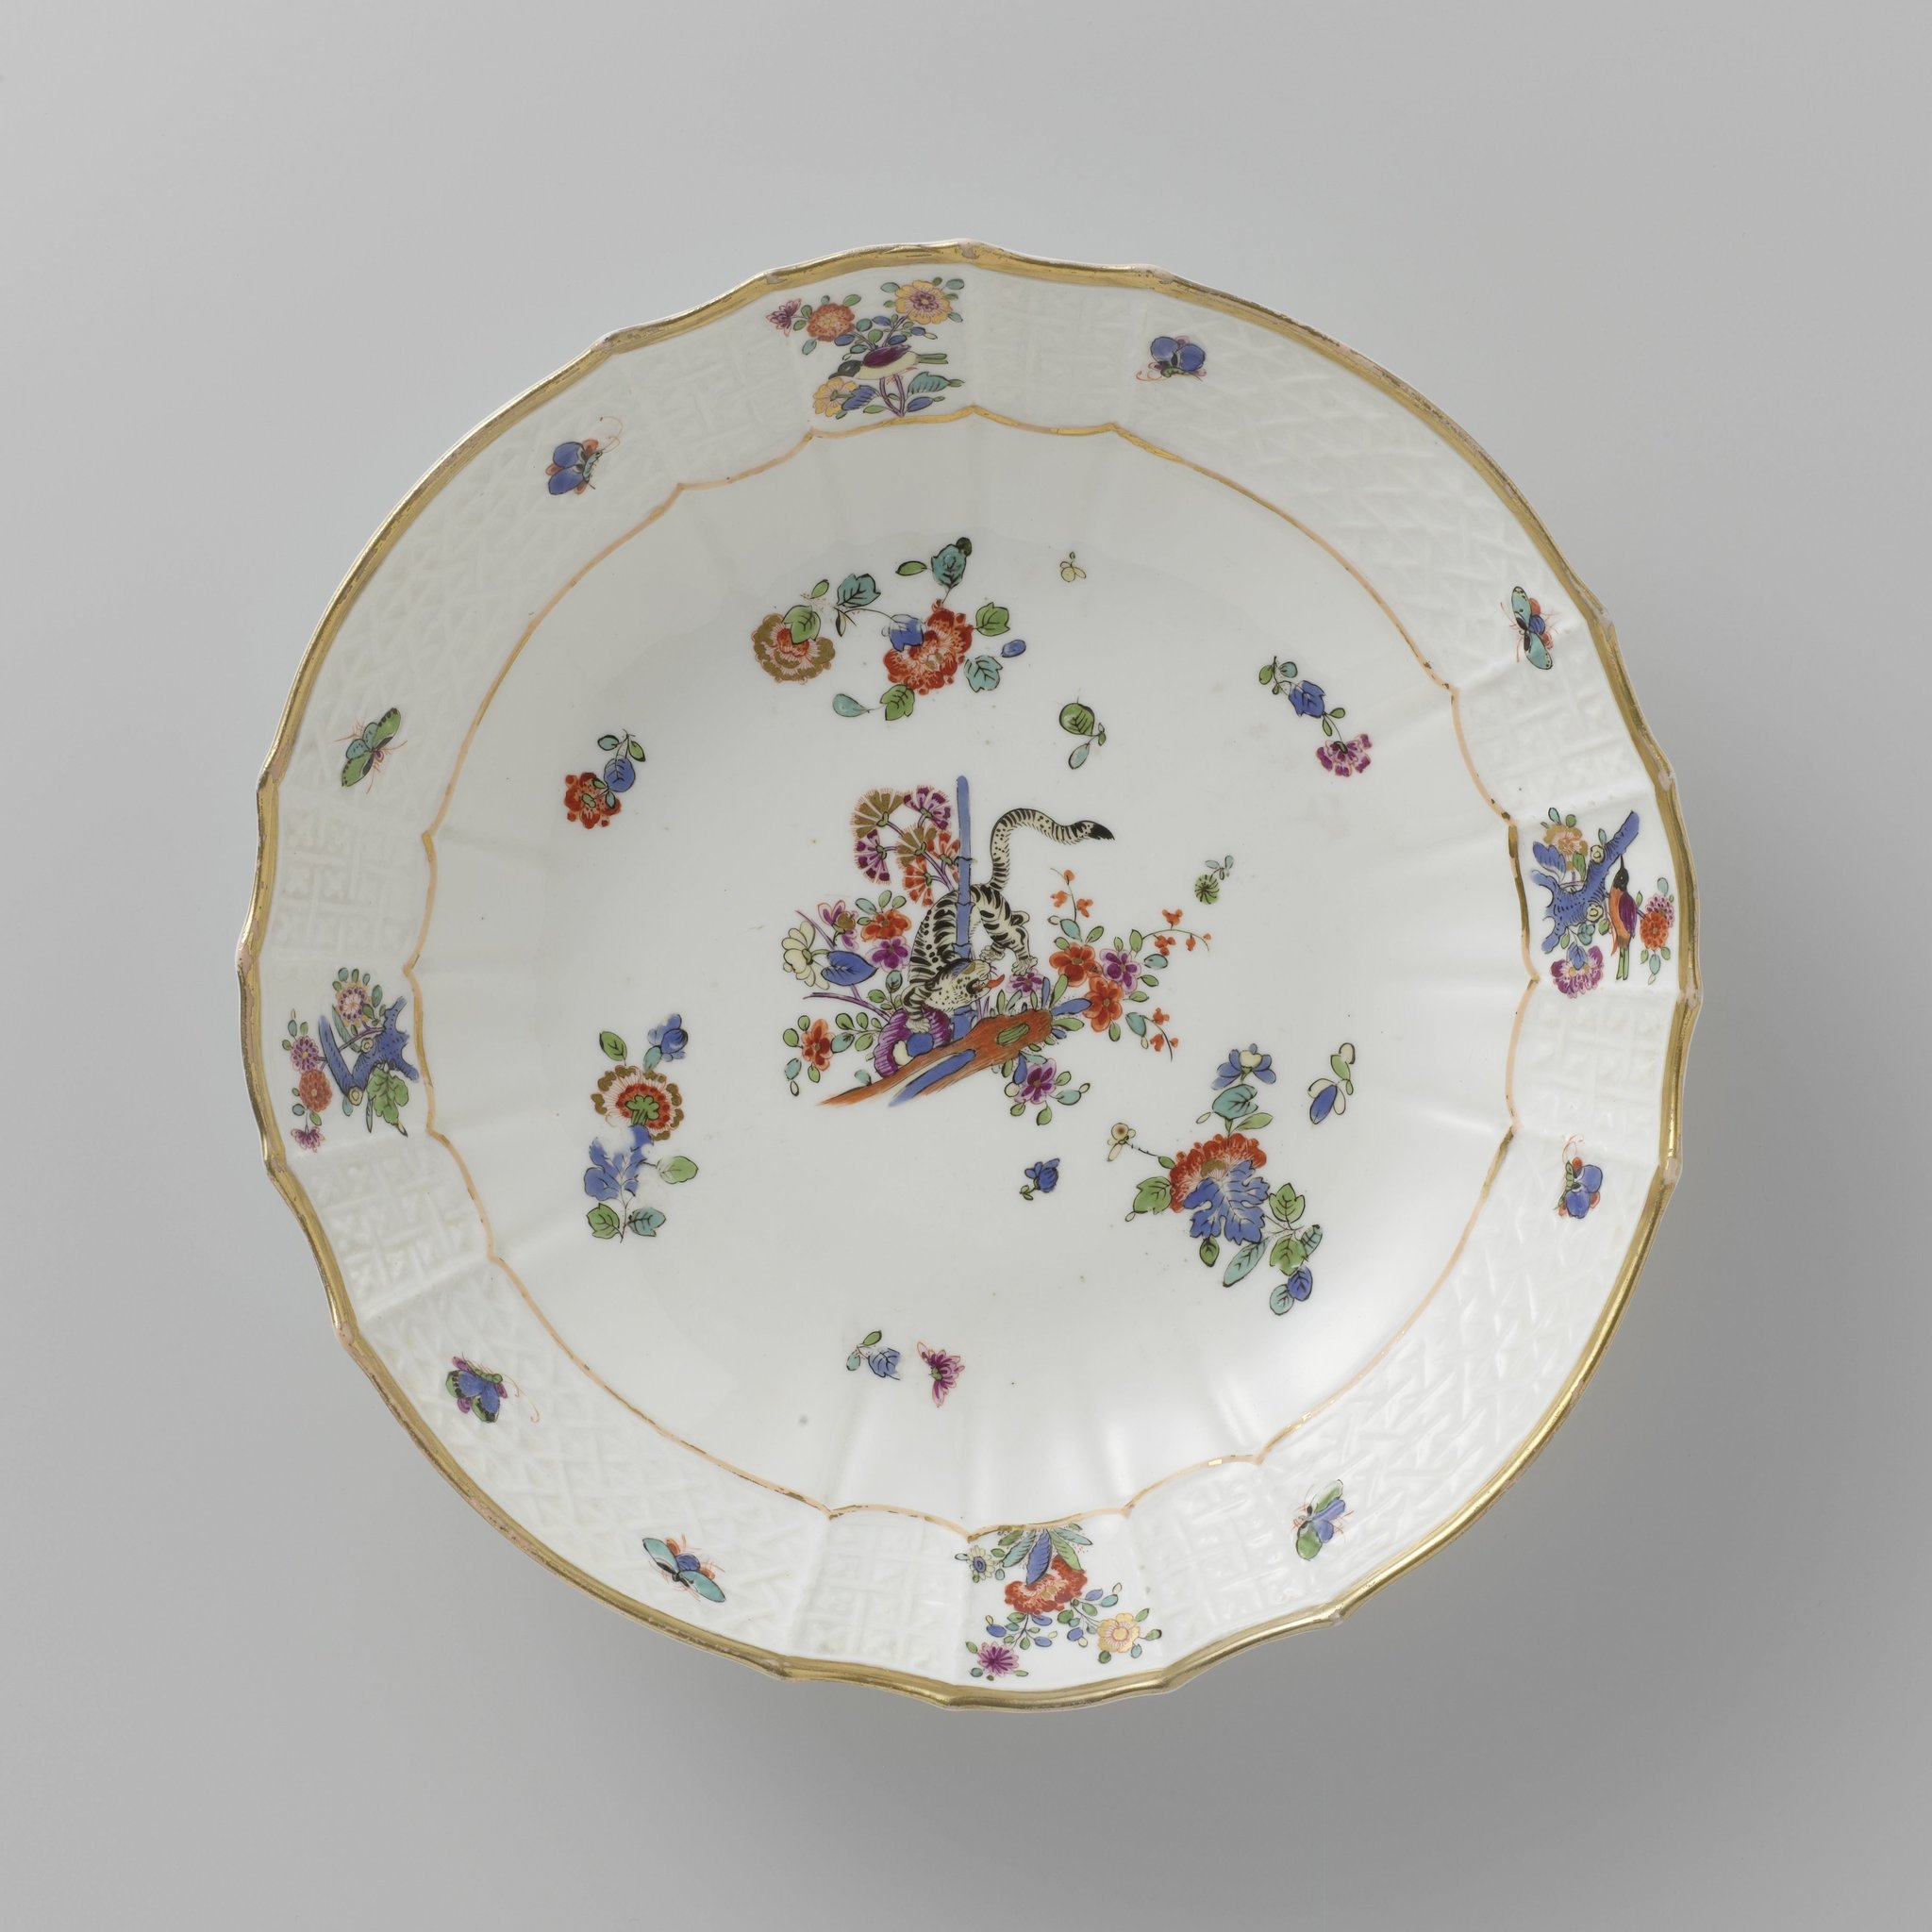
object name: platter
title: Schotel, veelkleurig beschilderd met een Kakiemon-decor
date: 1740-1745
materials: porcelain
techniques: painted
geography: meissen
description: Ronde schotel van beschilderd porselein. De schotel heeft een geribde en geschulpte rand. De schotel is beschilderd met een tijger om een bamboestengel, gestrooide Indianische Blumen, vlinders en takken met vogels. De rand is versierd met het 'Altbrandenstein'-patroon. De schotel is gemerkt.